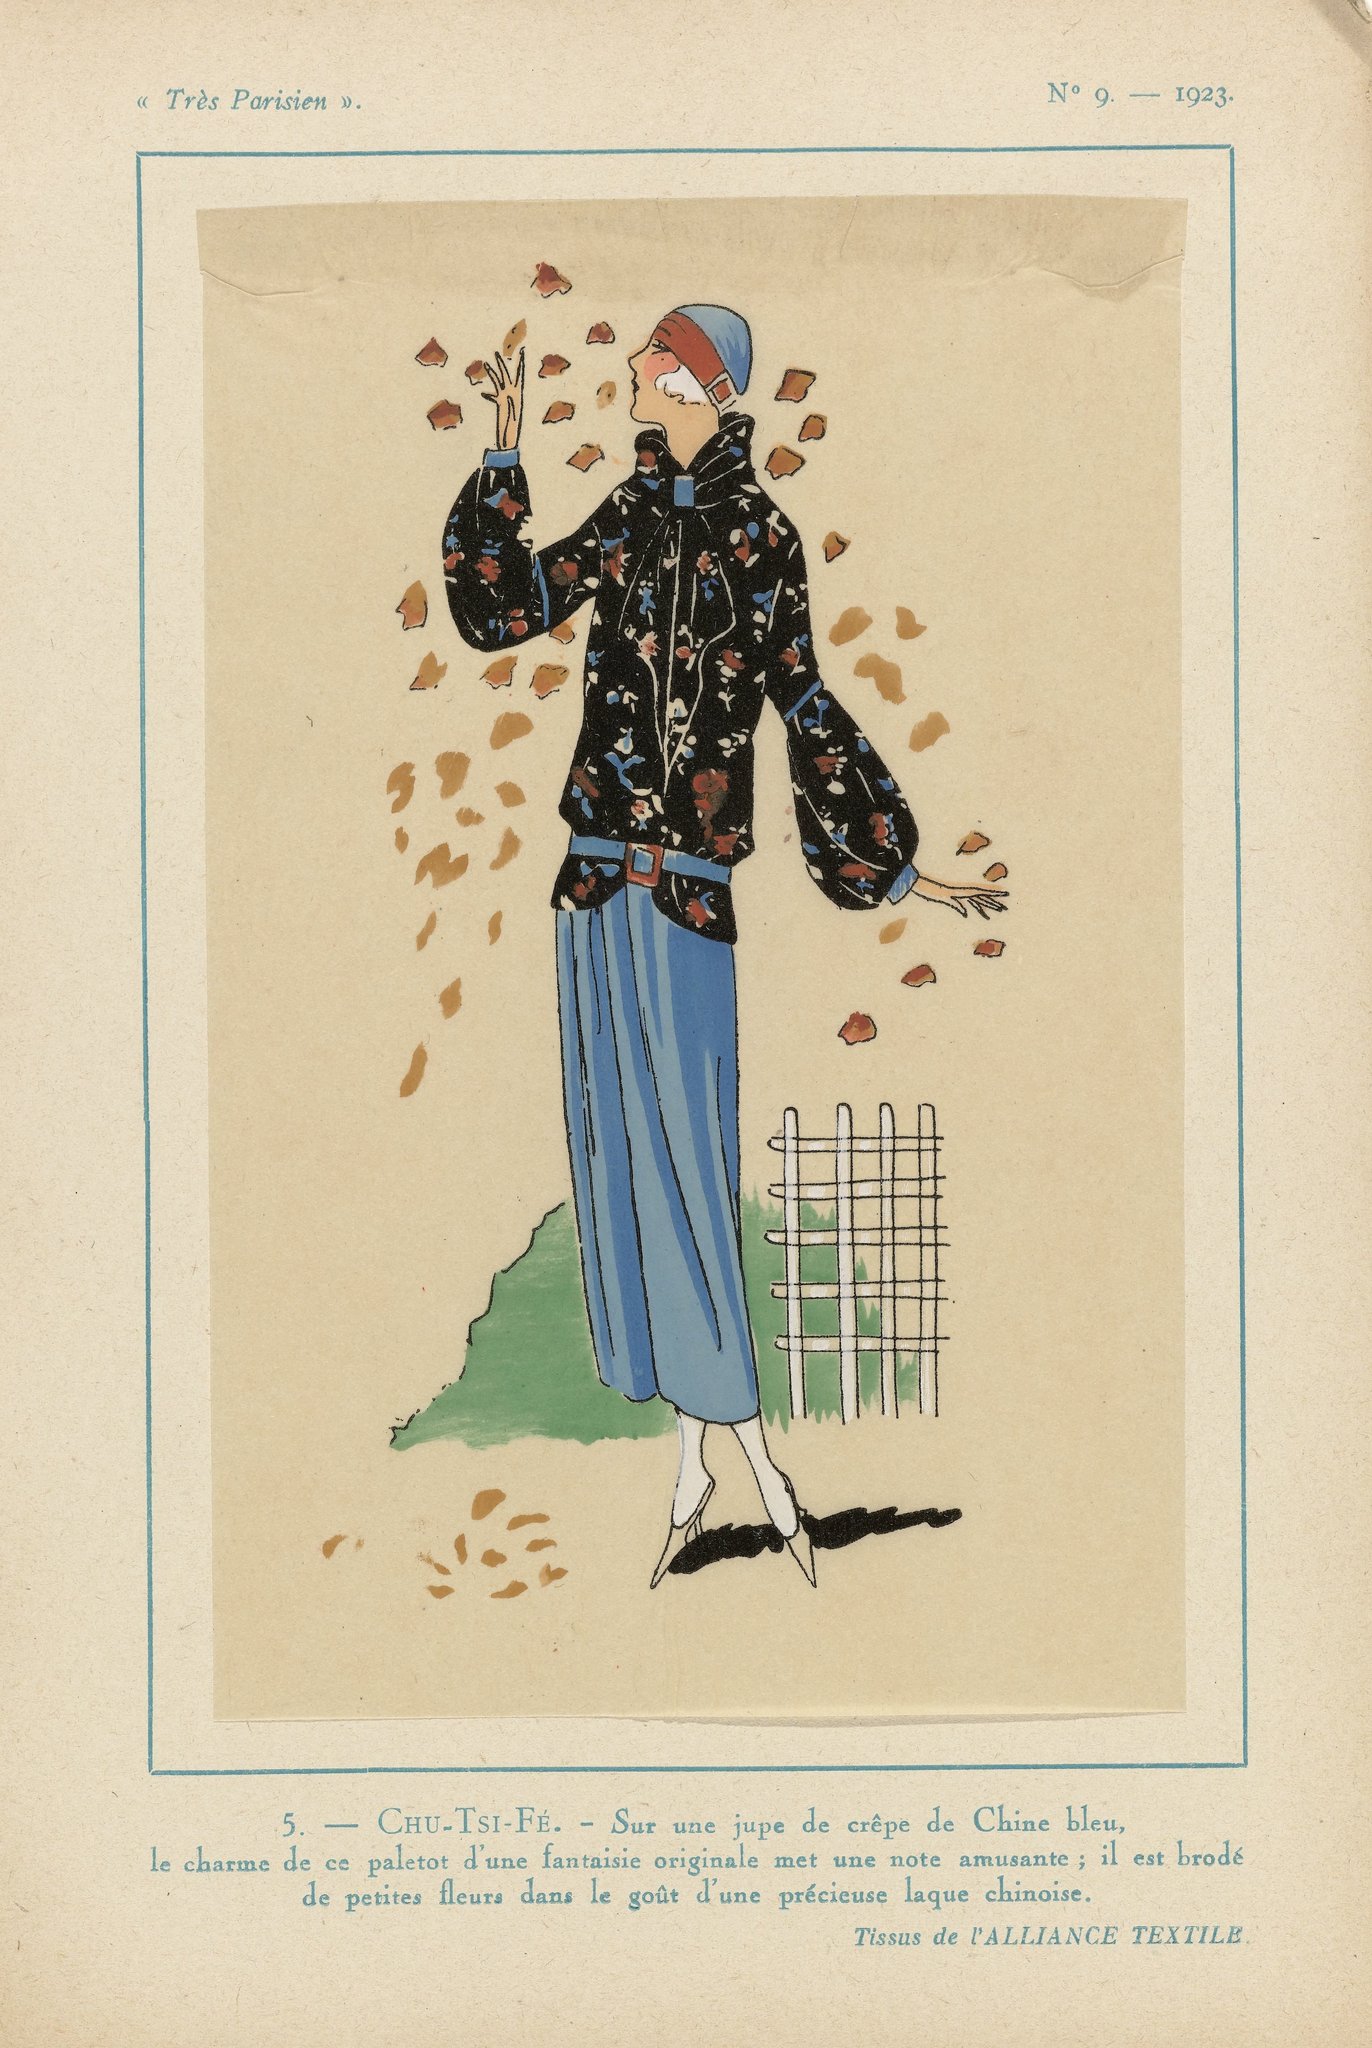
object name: fashion print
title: Très Parisien, 1923, No 9: 5. - CHU-TSI-FÉ. - Sur une jupe de crêpe de Chine...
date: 1923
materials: paper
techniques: hand coloring, letterpress printing, lithography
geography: paris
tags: embroidery (ornamentation) (+ women's clothes), coat: overcoat (+ women's clothes), fashion plates, head-gear: hat (+ women's clothes), skirt (+ women's clothes)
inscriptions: caption: ‘5. - CHU-TSI-FÉ. - Sur une jupe de crêpe de Chine bleu, le charme de ce paletot d'une fantaisie originale met une note amusante; il est brodé de petites fleurs dans le goût d'une précieuse laque chinoise. / Tissus de l'ALLIANCE TEXTILE.’, title: ‘Très Parisien / No 9. - 1923’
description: Rok van blauwe 'crêpe de Chine' en een paletot geborduurd met kleine bloemen in de stijl van Chinees lakwerk. Stoffen van Alliance Textile. Prent uit het modetijdschrift Très Parisien (1920-1936).